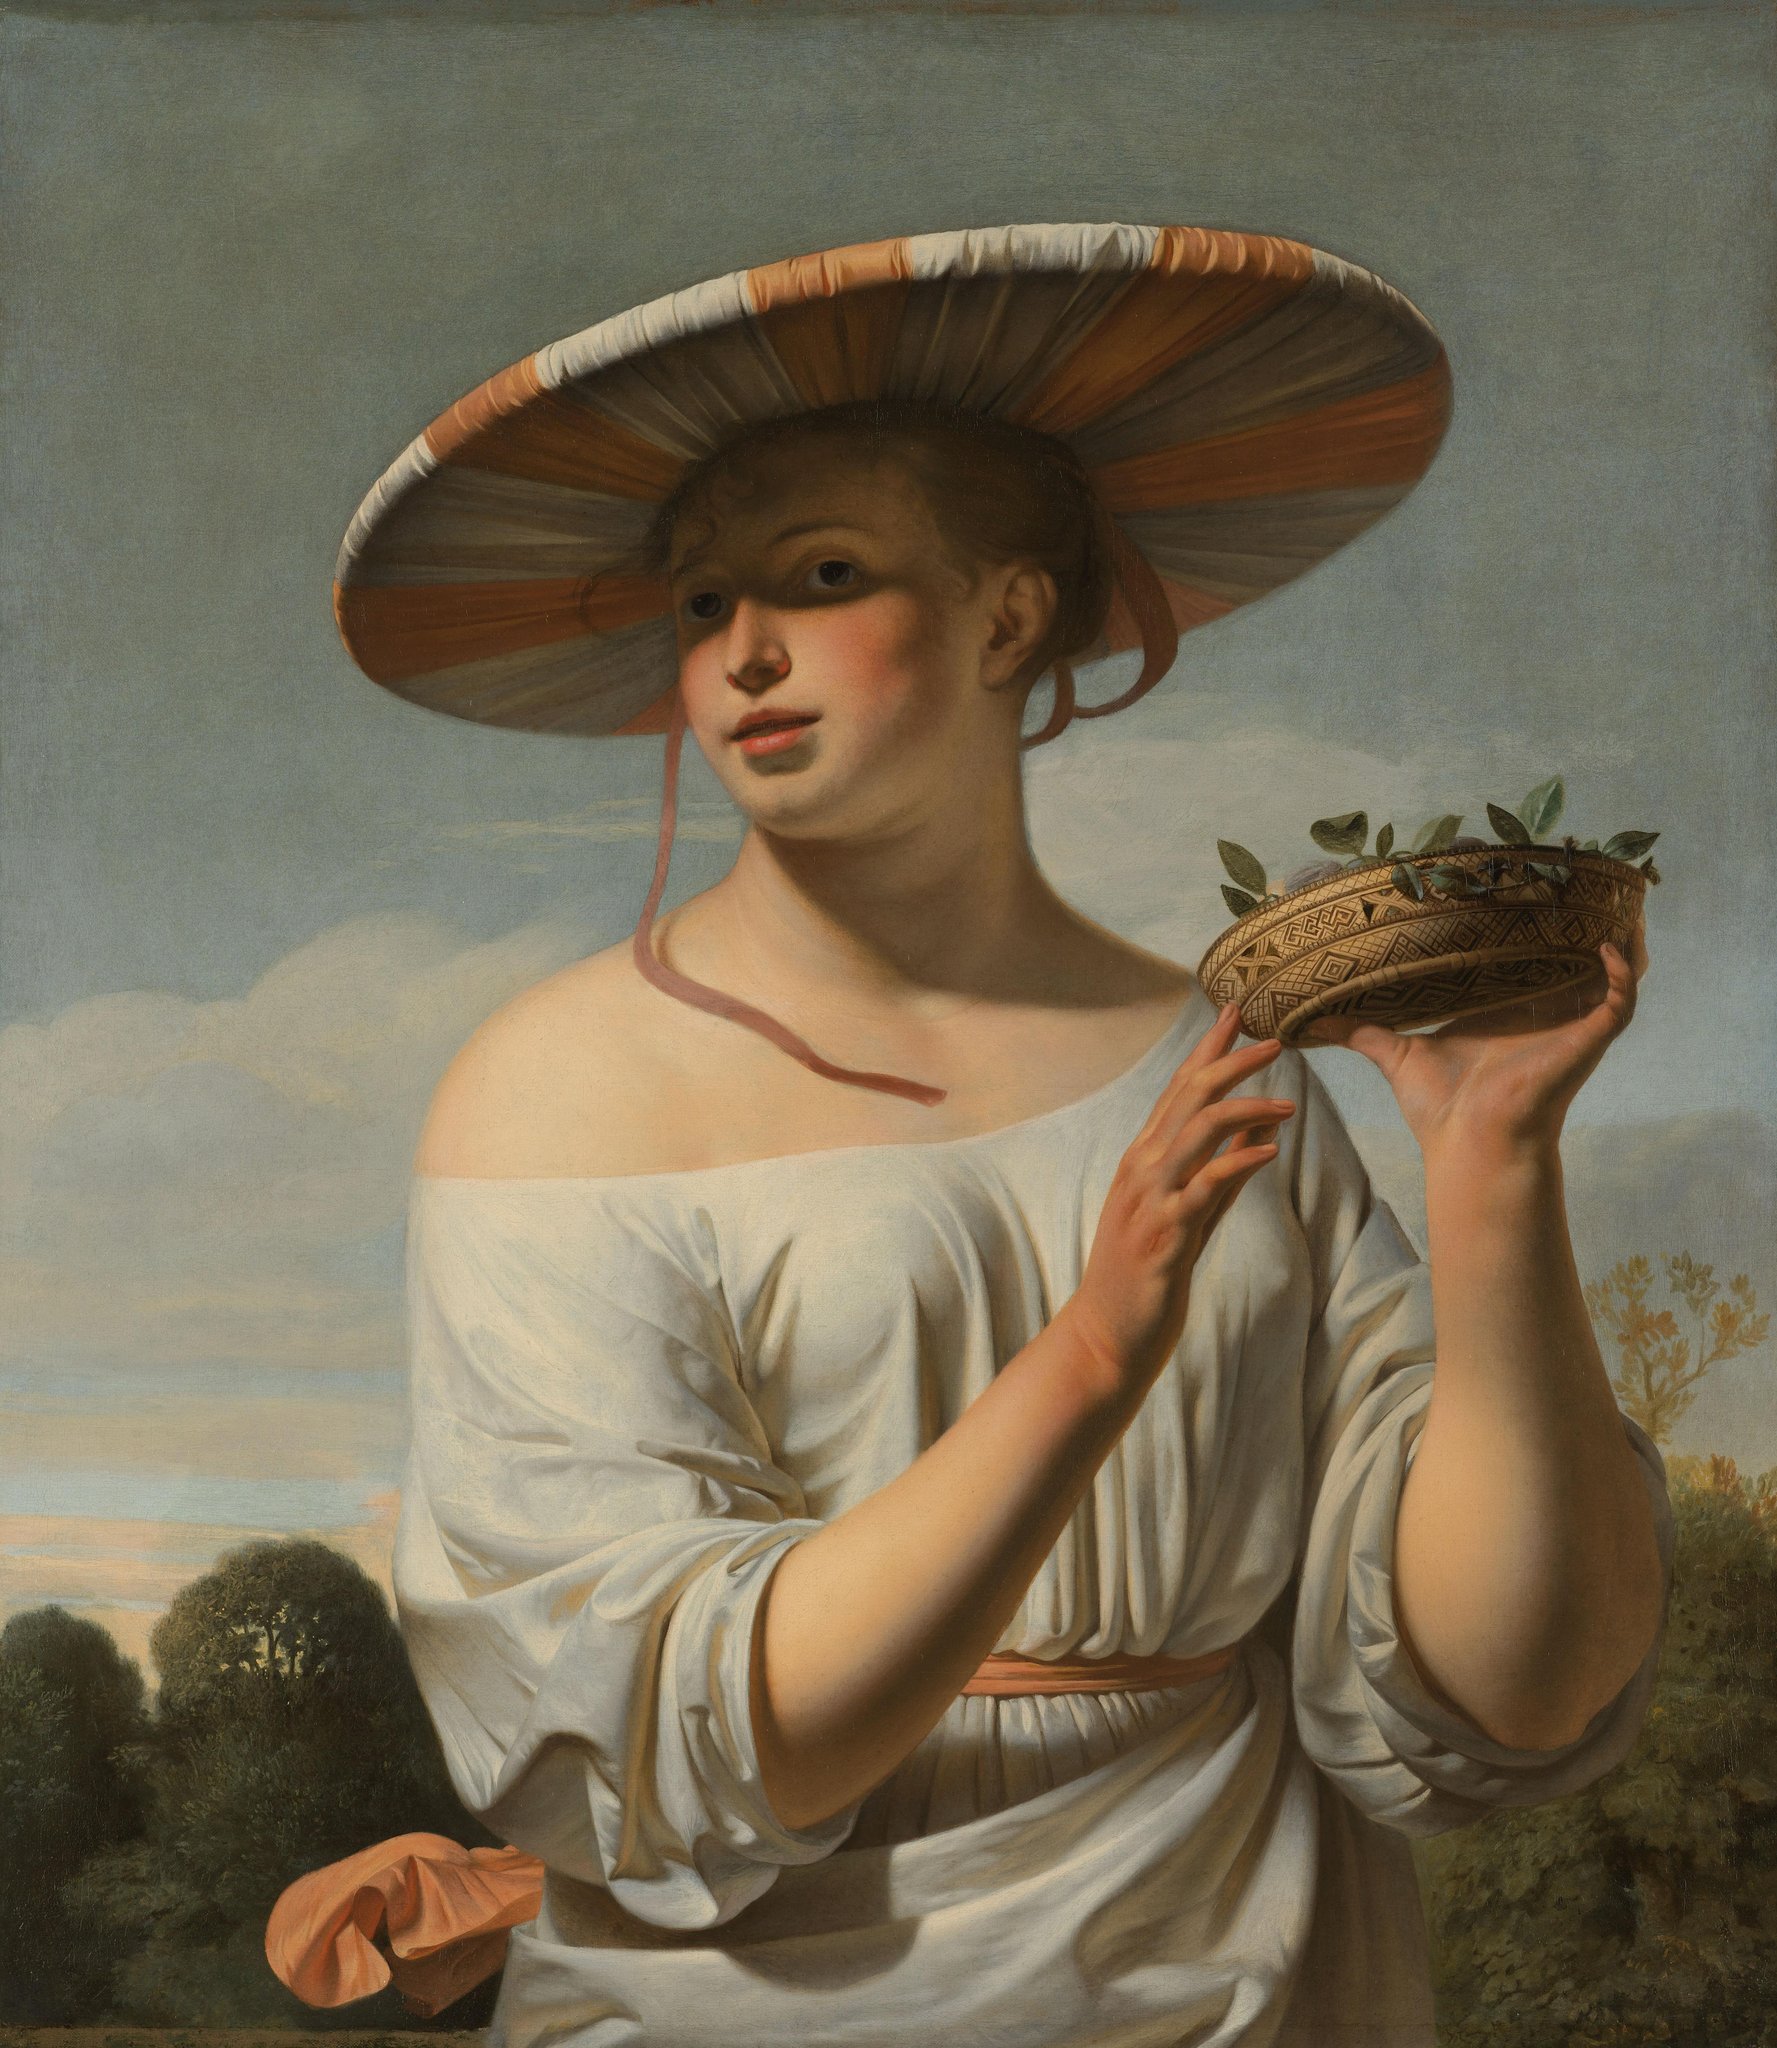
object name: painting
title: Woman in a Large Hat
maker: caesar van everdingen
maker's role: draughtsman, painter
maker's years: 1616-1678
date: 1650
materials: canvas, oil, paint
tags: fruits: plum, adolescent, young woman, maiden, head-gear: hat (+ women's clothes), summer, 'aestas'; 'estate' (ripa) (+ human occupations representing seasons and months)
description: The plums in the basket and the woman’s subtly exposed shoulder imbue the painting with an erotic undertone. The type of hat atop her head was mostly worn by Romani women at the time. Such hats were worn at the court in The Hague during costume parties and parades. Van Everdingen enjoyed recognition at court, having received several commissions from it.